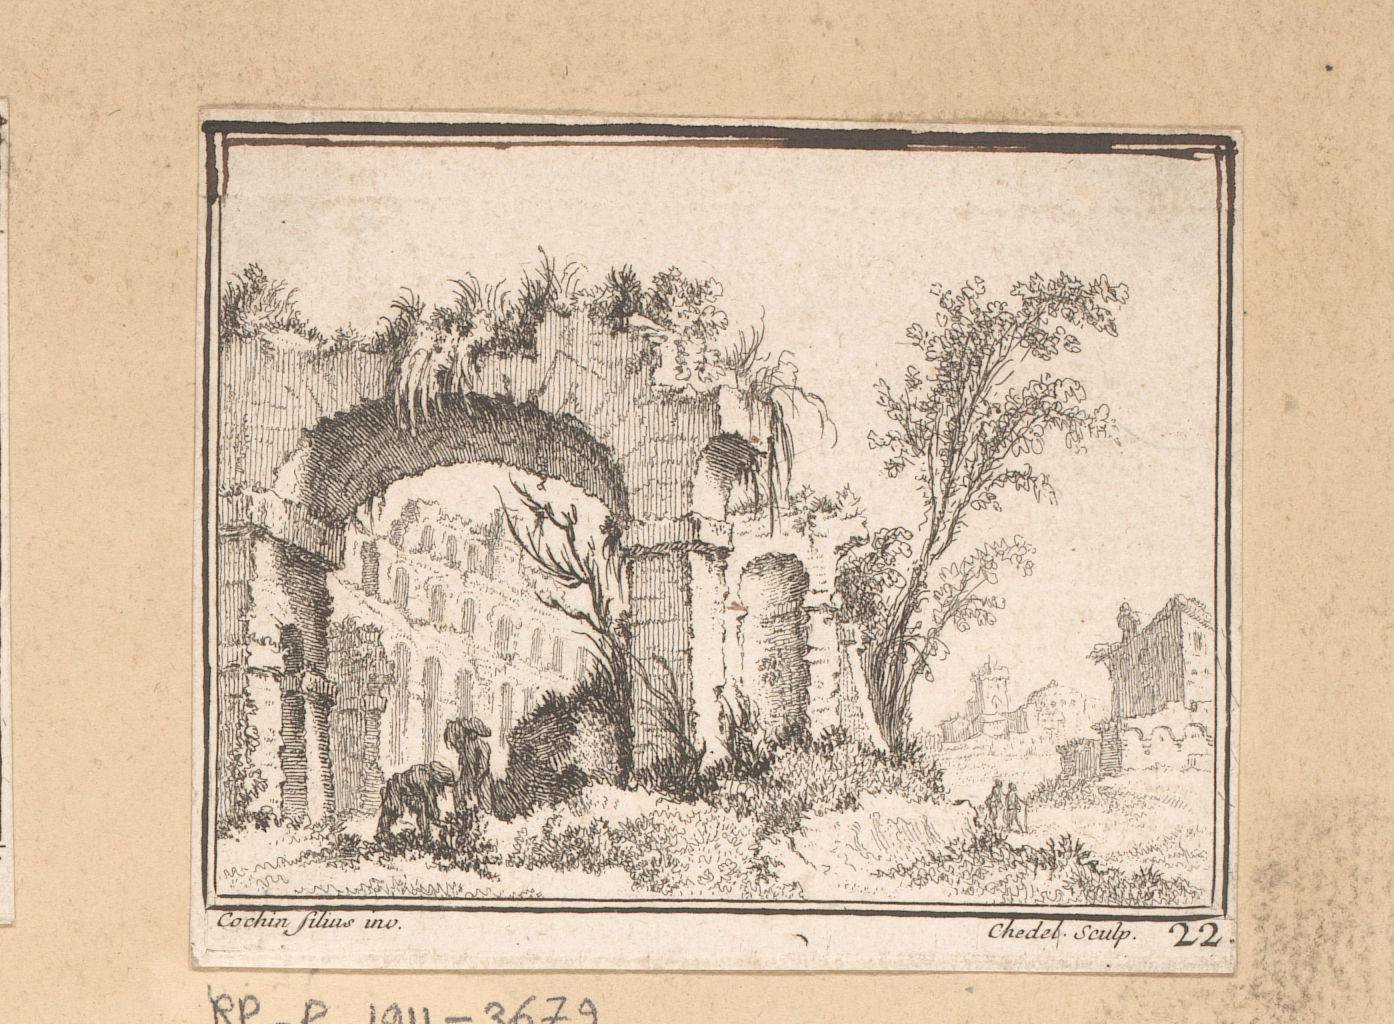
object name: print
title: Landschap met twee figuren bij een vervallen en begroeide poort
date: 1725-1763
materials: ink, paper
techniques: etching, pen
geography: france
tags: landscape with ruins, gate, entrance, landscapes (+ landscape with figures, staffage)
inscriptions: collector's mark: Lugt 2228